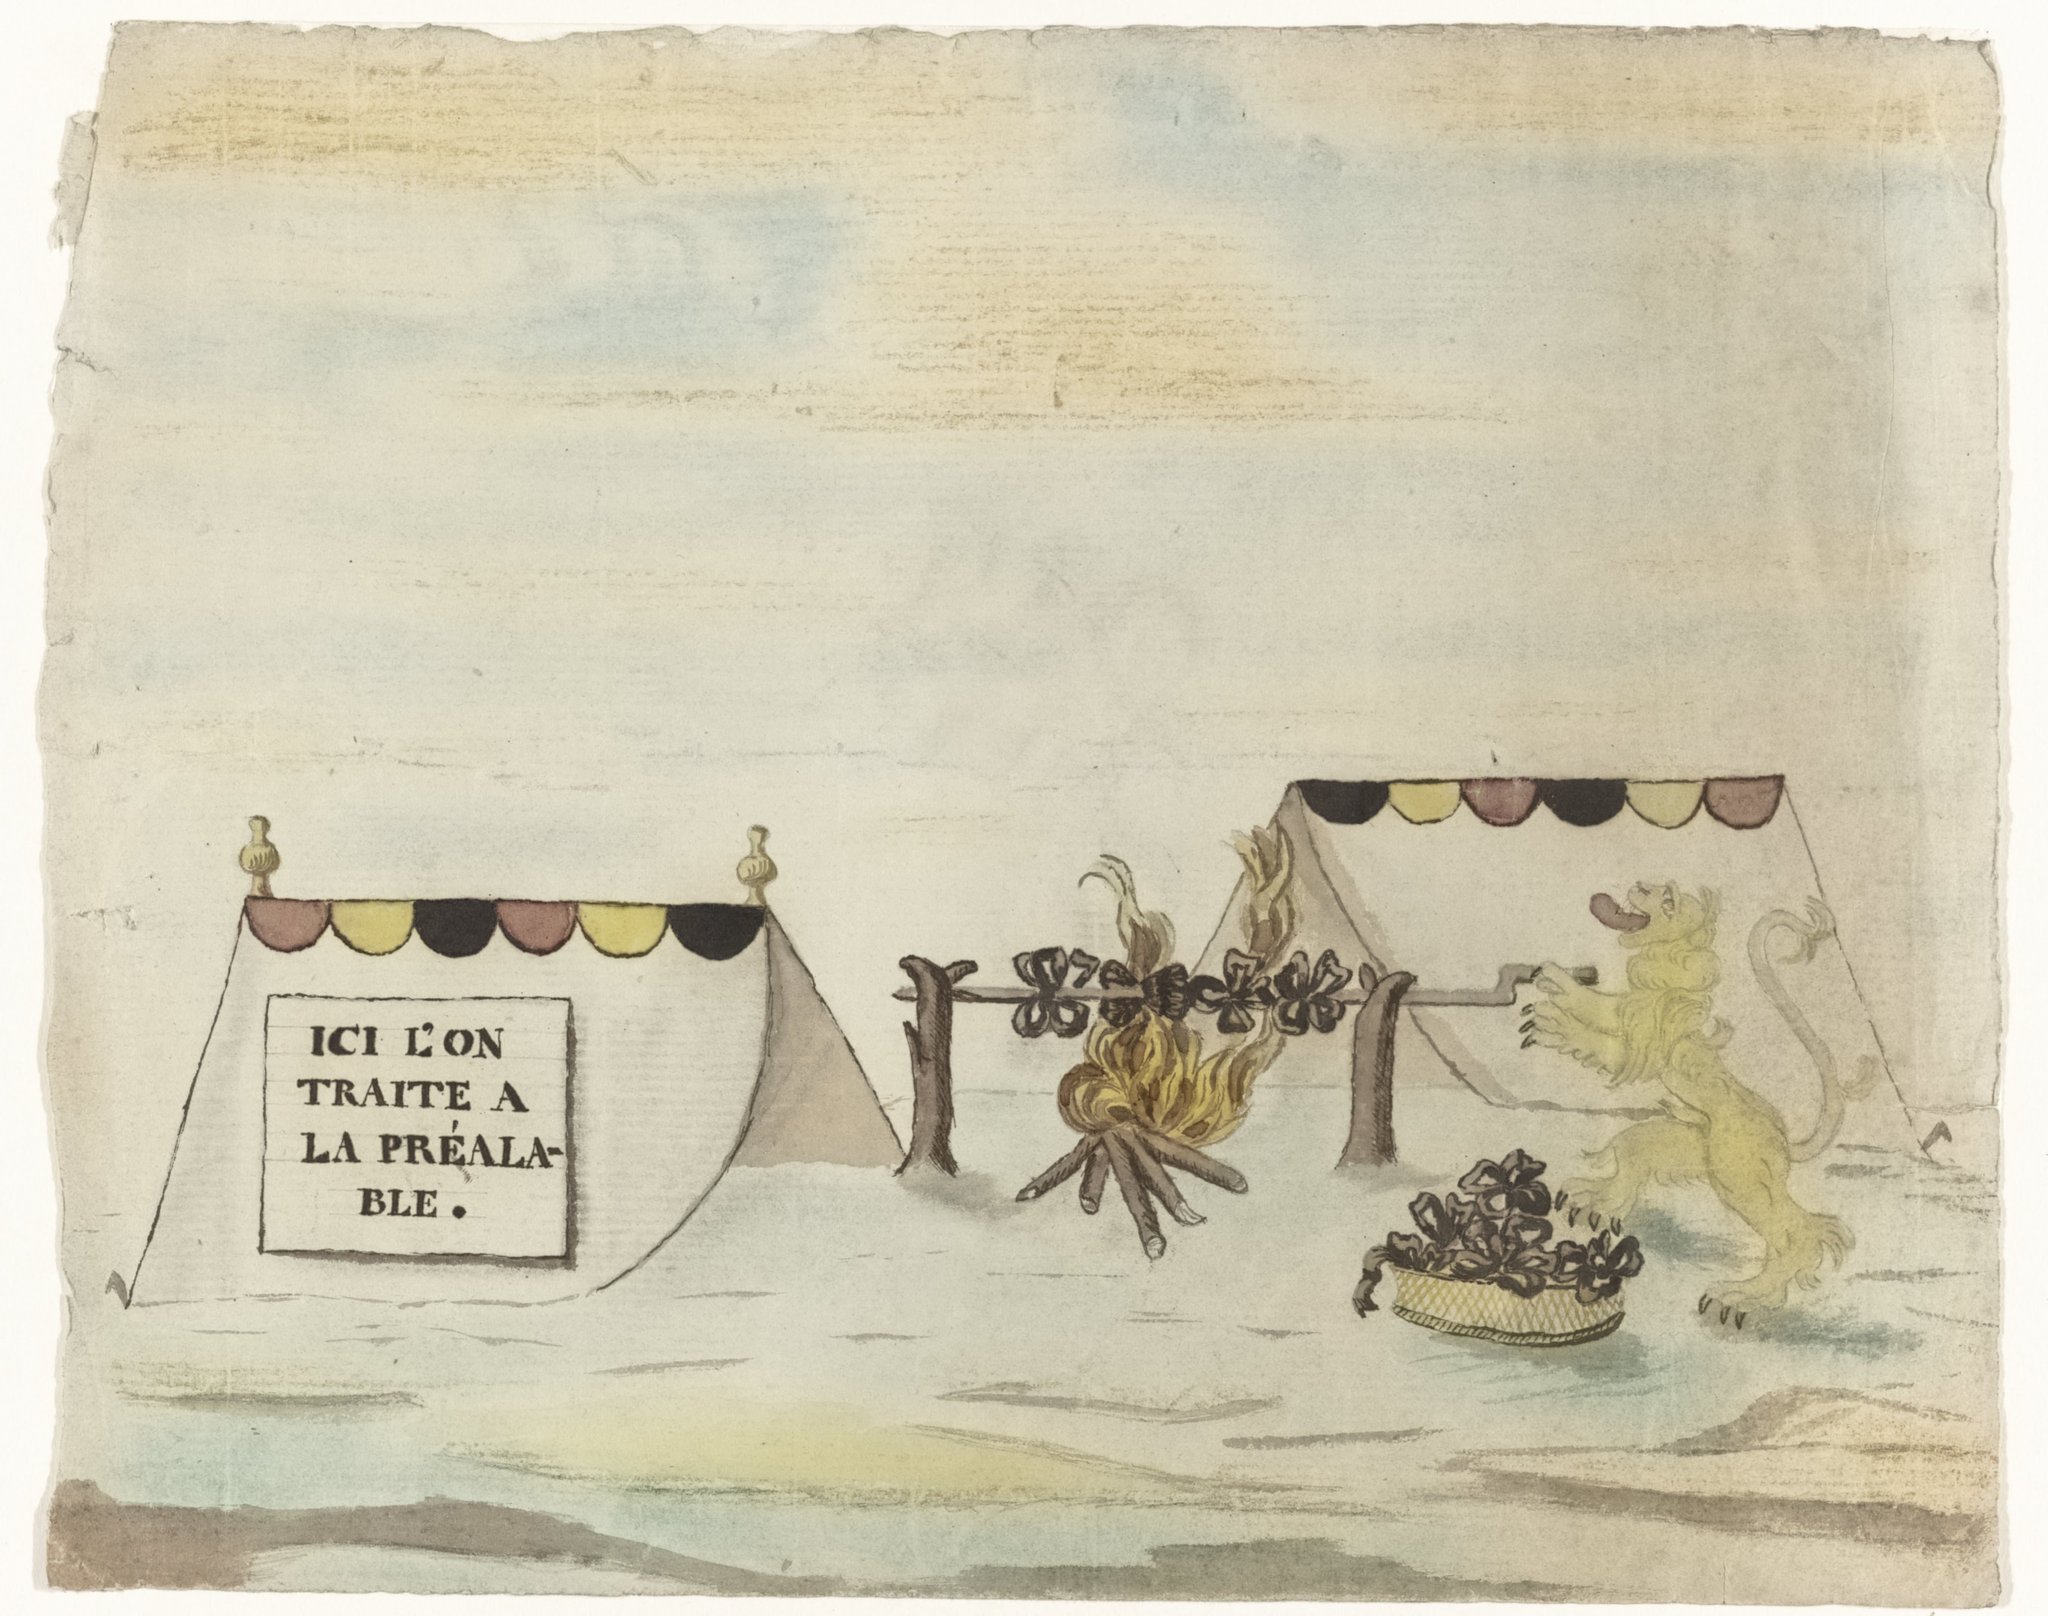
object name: drawing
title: Brabantse Omwenteling, 1787-1790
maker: Anonymous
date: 1787-1791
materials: paper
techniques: writing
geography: southern netherlands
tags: spit ~ cooking - cc - in the open air, brabant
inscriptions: collector's mark: Lugt 2228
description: De Brabantse leeuw roostert kokardes aan een spit boven een vuurtje. Links en rechts twee tenten. Onderdeel van een grote groep van prenten betrekking hebbend op de gebeurtenissen van de Brabantse Omwenteling en de periode 1787-1790.